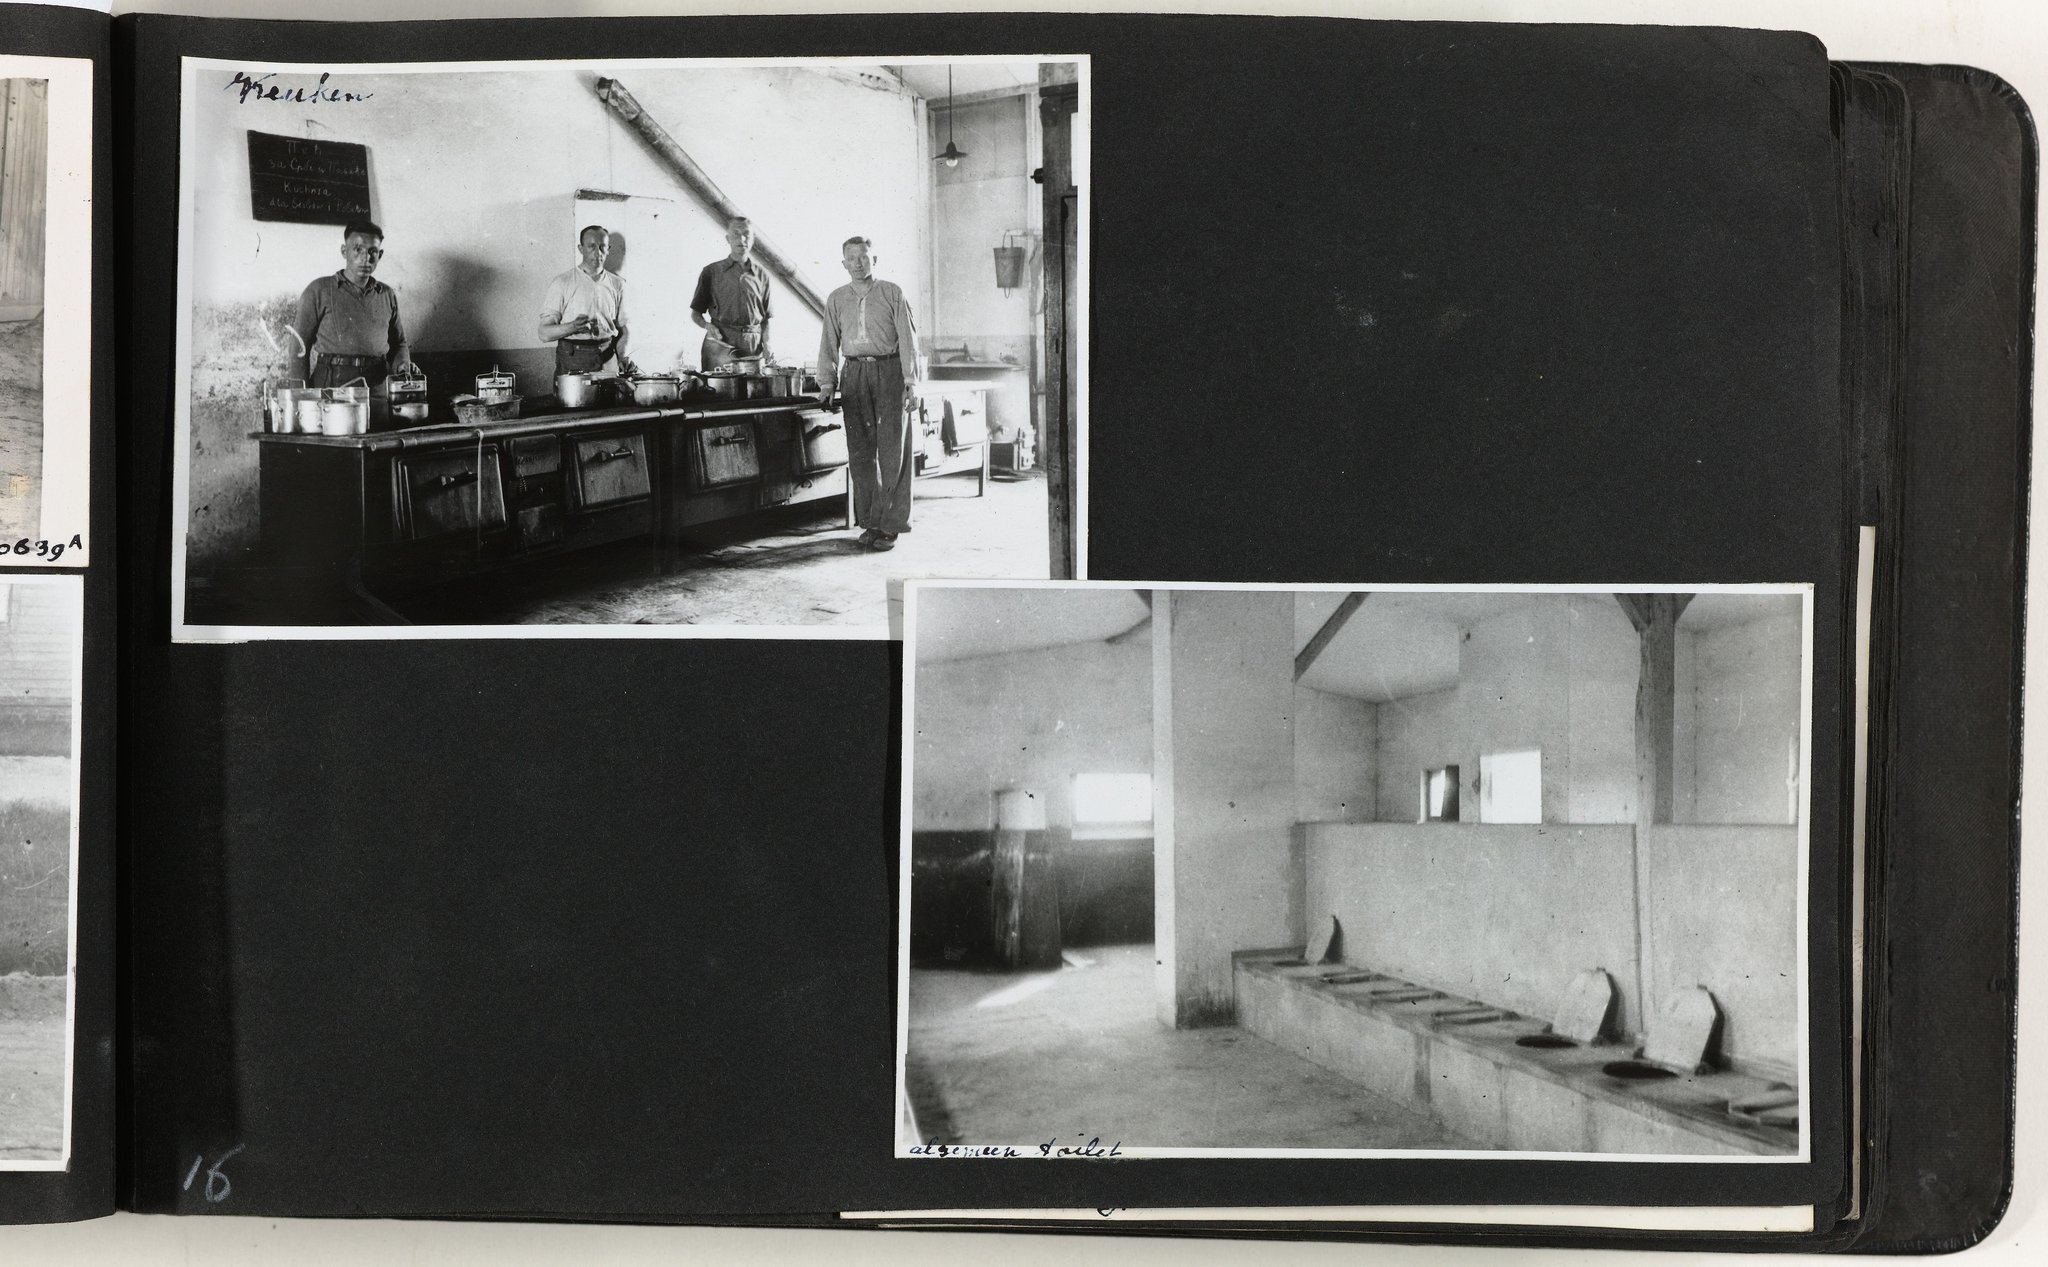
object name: photograph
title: Keuken / algemeen toilet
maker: dick w.b. van maarseveen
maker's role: fotograaf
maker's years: 1905-1990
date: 1943-1945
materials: cardboard, photographic support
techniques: gelatin silver print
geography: muhlberg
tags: the hague, dick w.b. van maarseveen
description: Albumblad met twee foto’s: de keuken met vier gevangenen en de algemene toiletten. Onderdeel van een fotoalbum met foto's door Dick van Maarseveen van het krijgsgevangenenkamp Stalag IV B in Mühlberg in de periode 1943-1945.